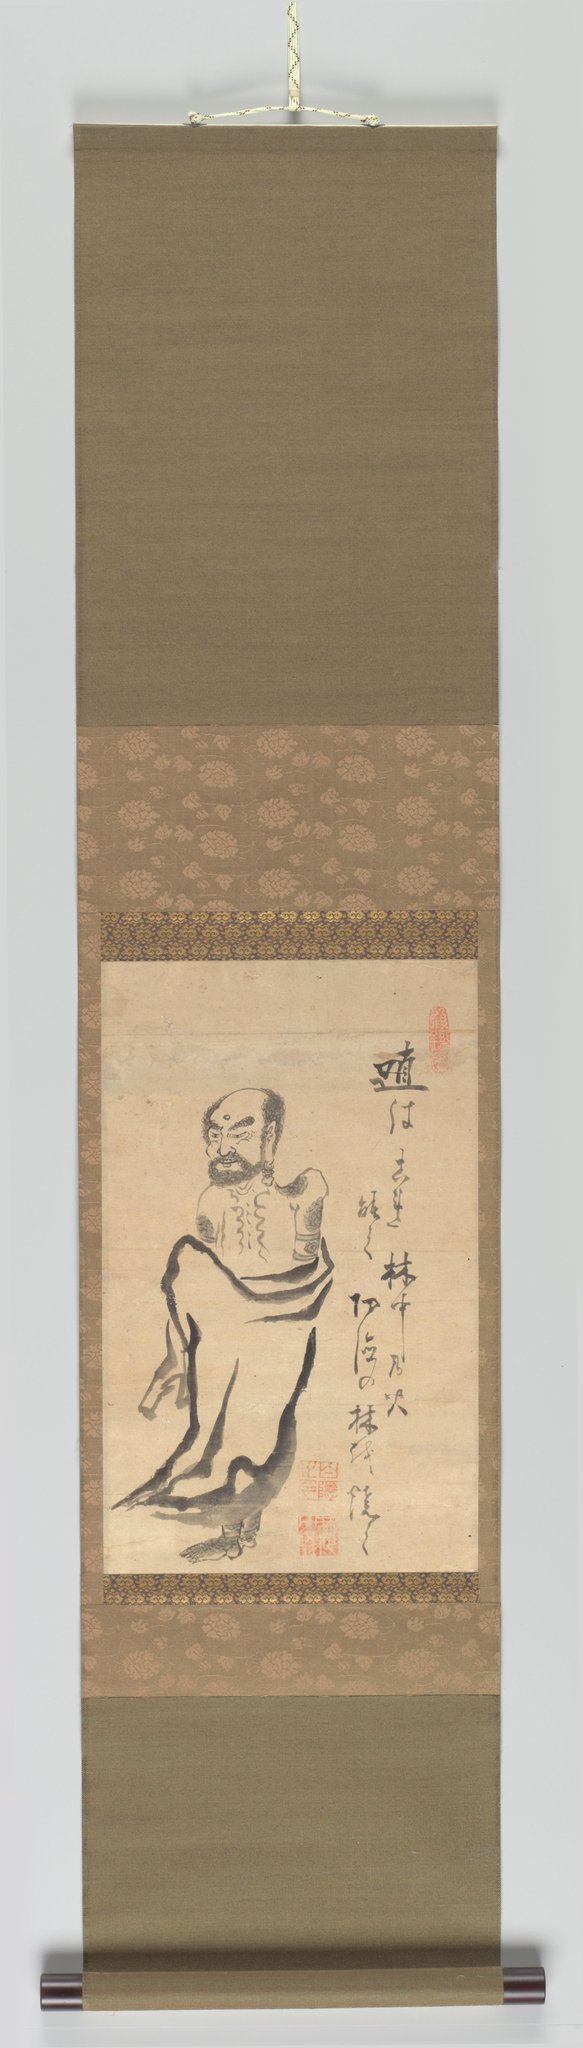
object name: hanging scroll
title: Sakyamuni (Buddha), Descending from the Mountain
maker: hakuin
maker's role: painter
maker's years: 1685-1769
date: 1685-1769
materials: ink, paper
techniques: calligraphy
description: Hakuin revived Zen painting in the 18th century with a precise characterization of the figures depicted. For example, here he aptly portrayed the resolve in Buddha’s face. Buddha descends from the mountain after having fasted and meditated for six years. He returns emaciated, yet in an enlightened state, ready to proclaim his message to the world.